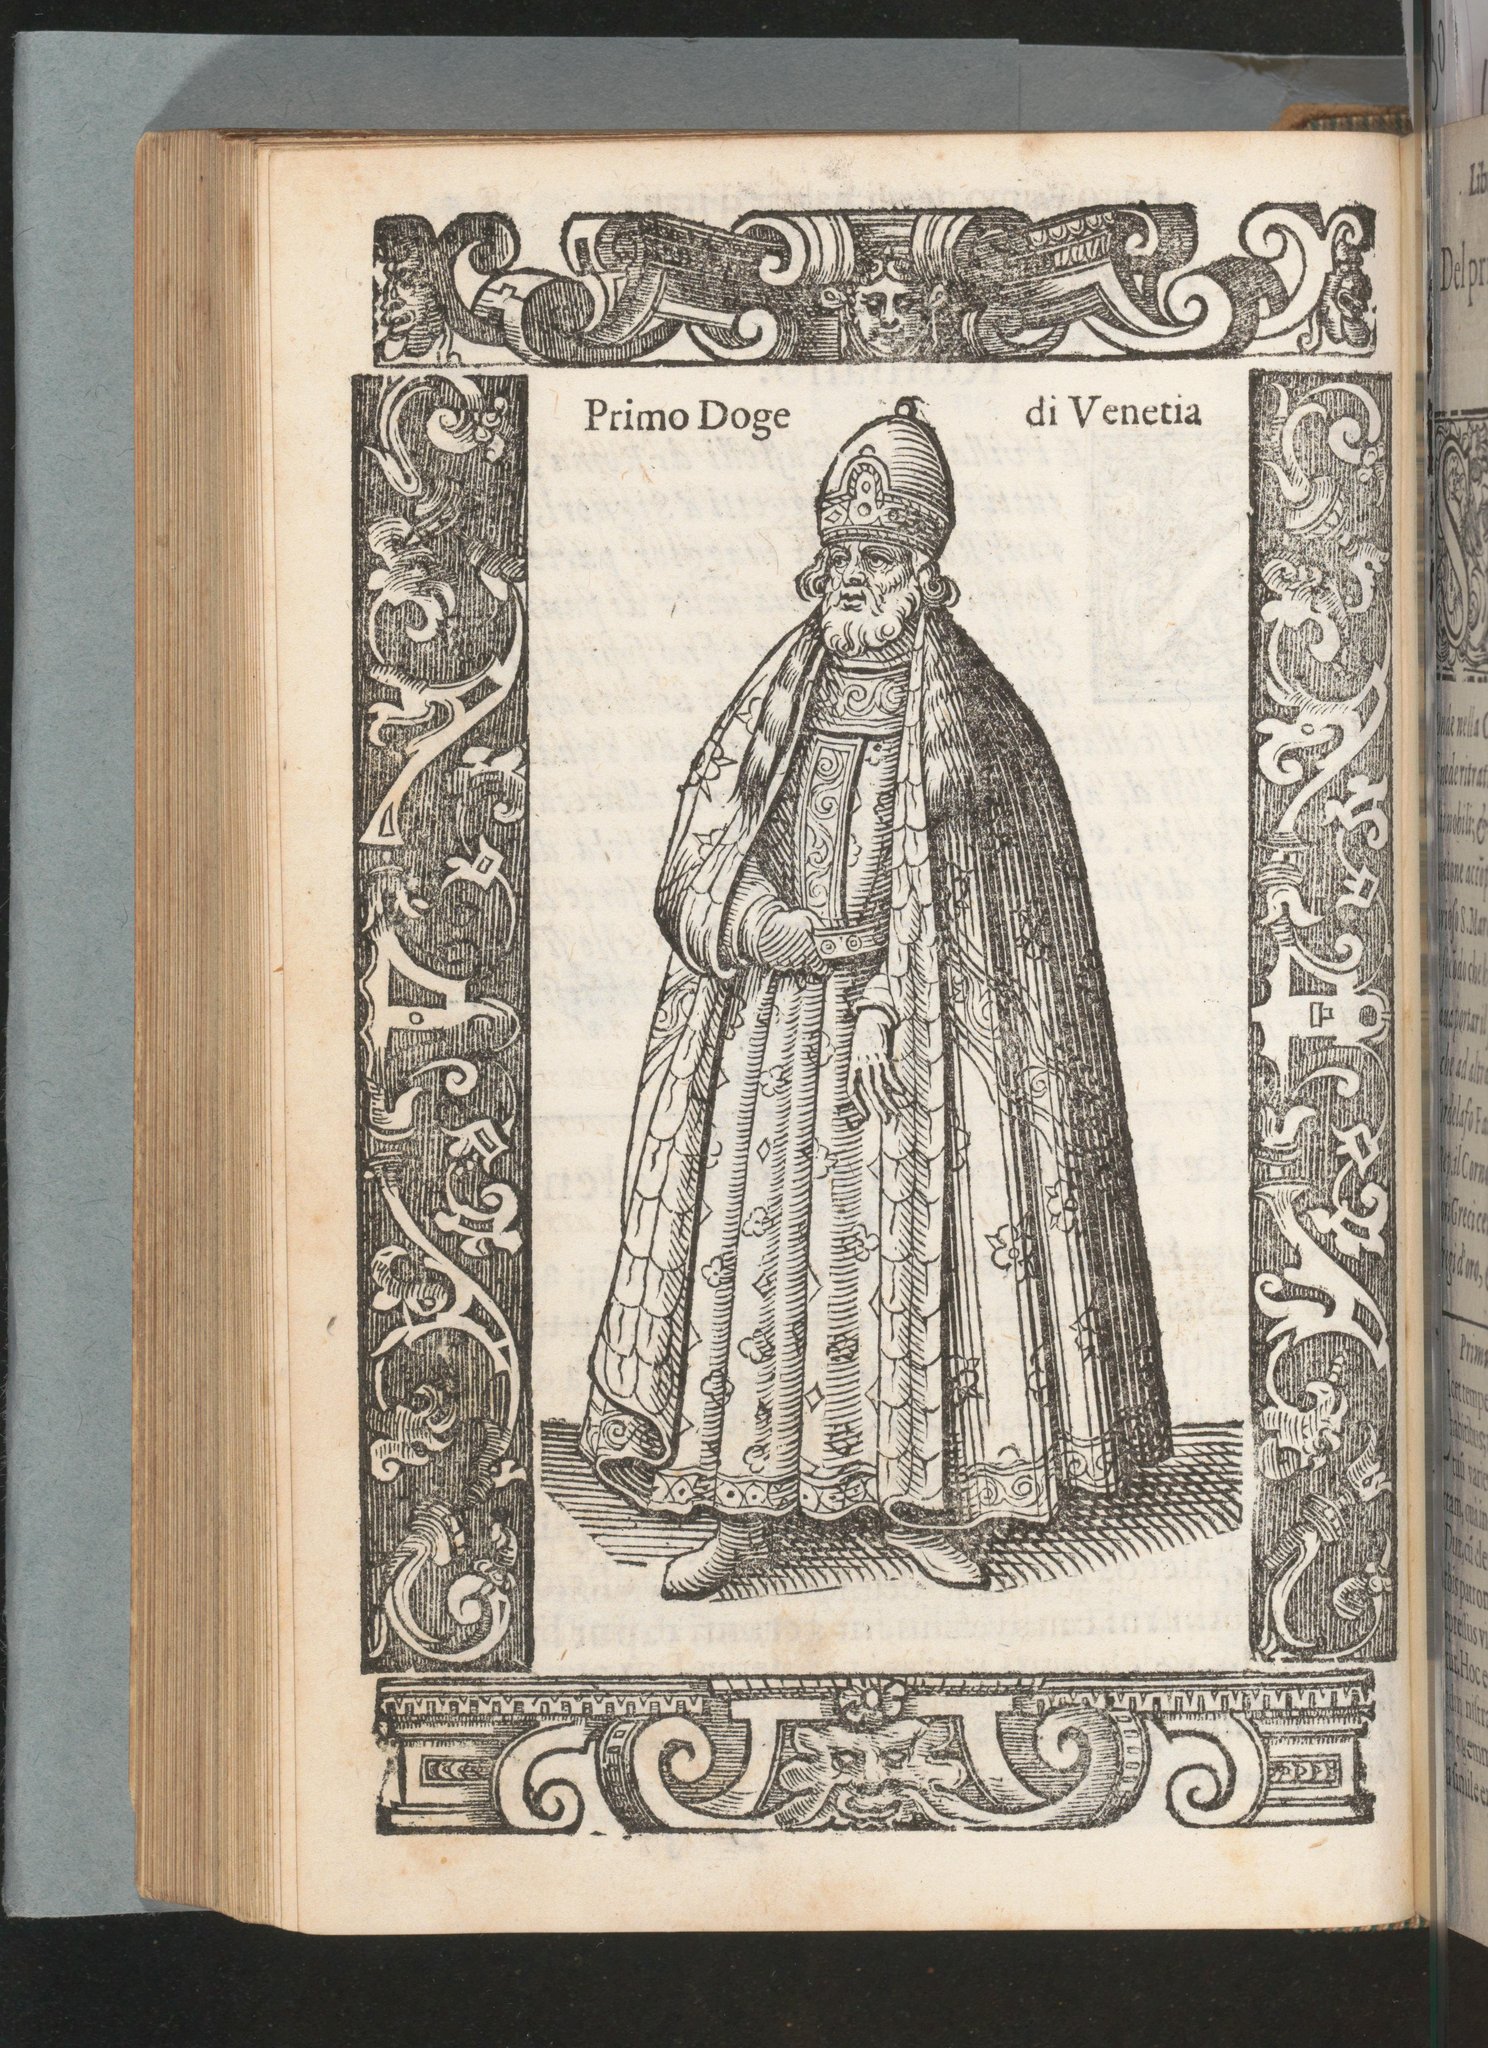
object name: costume print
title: Primo doge VENETIA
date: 1598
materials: paper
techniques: woodcut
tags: other sovereign: doge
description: Venetiaanse doge, zoals deze gekleed ging ca. 1100, op zijn hoofd een mijter die lijkt op de mijter van de paus. In ornamentrand